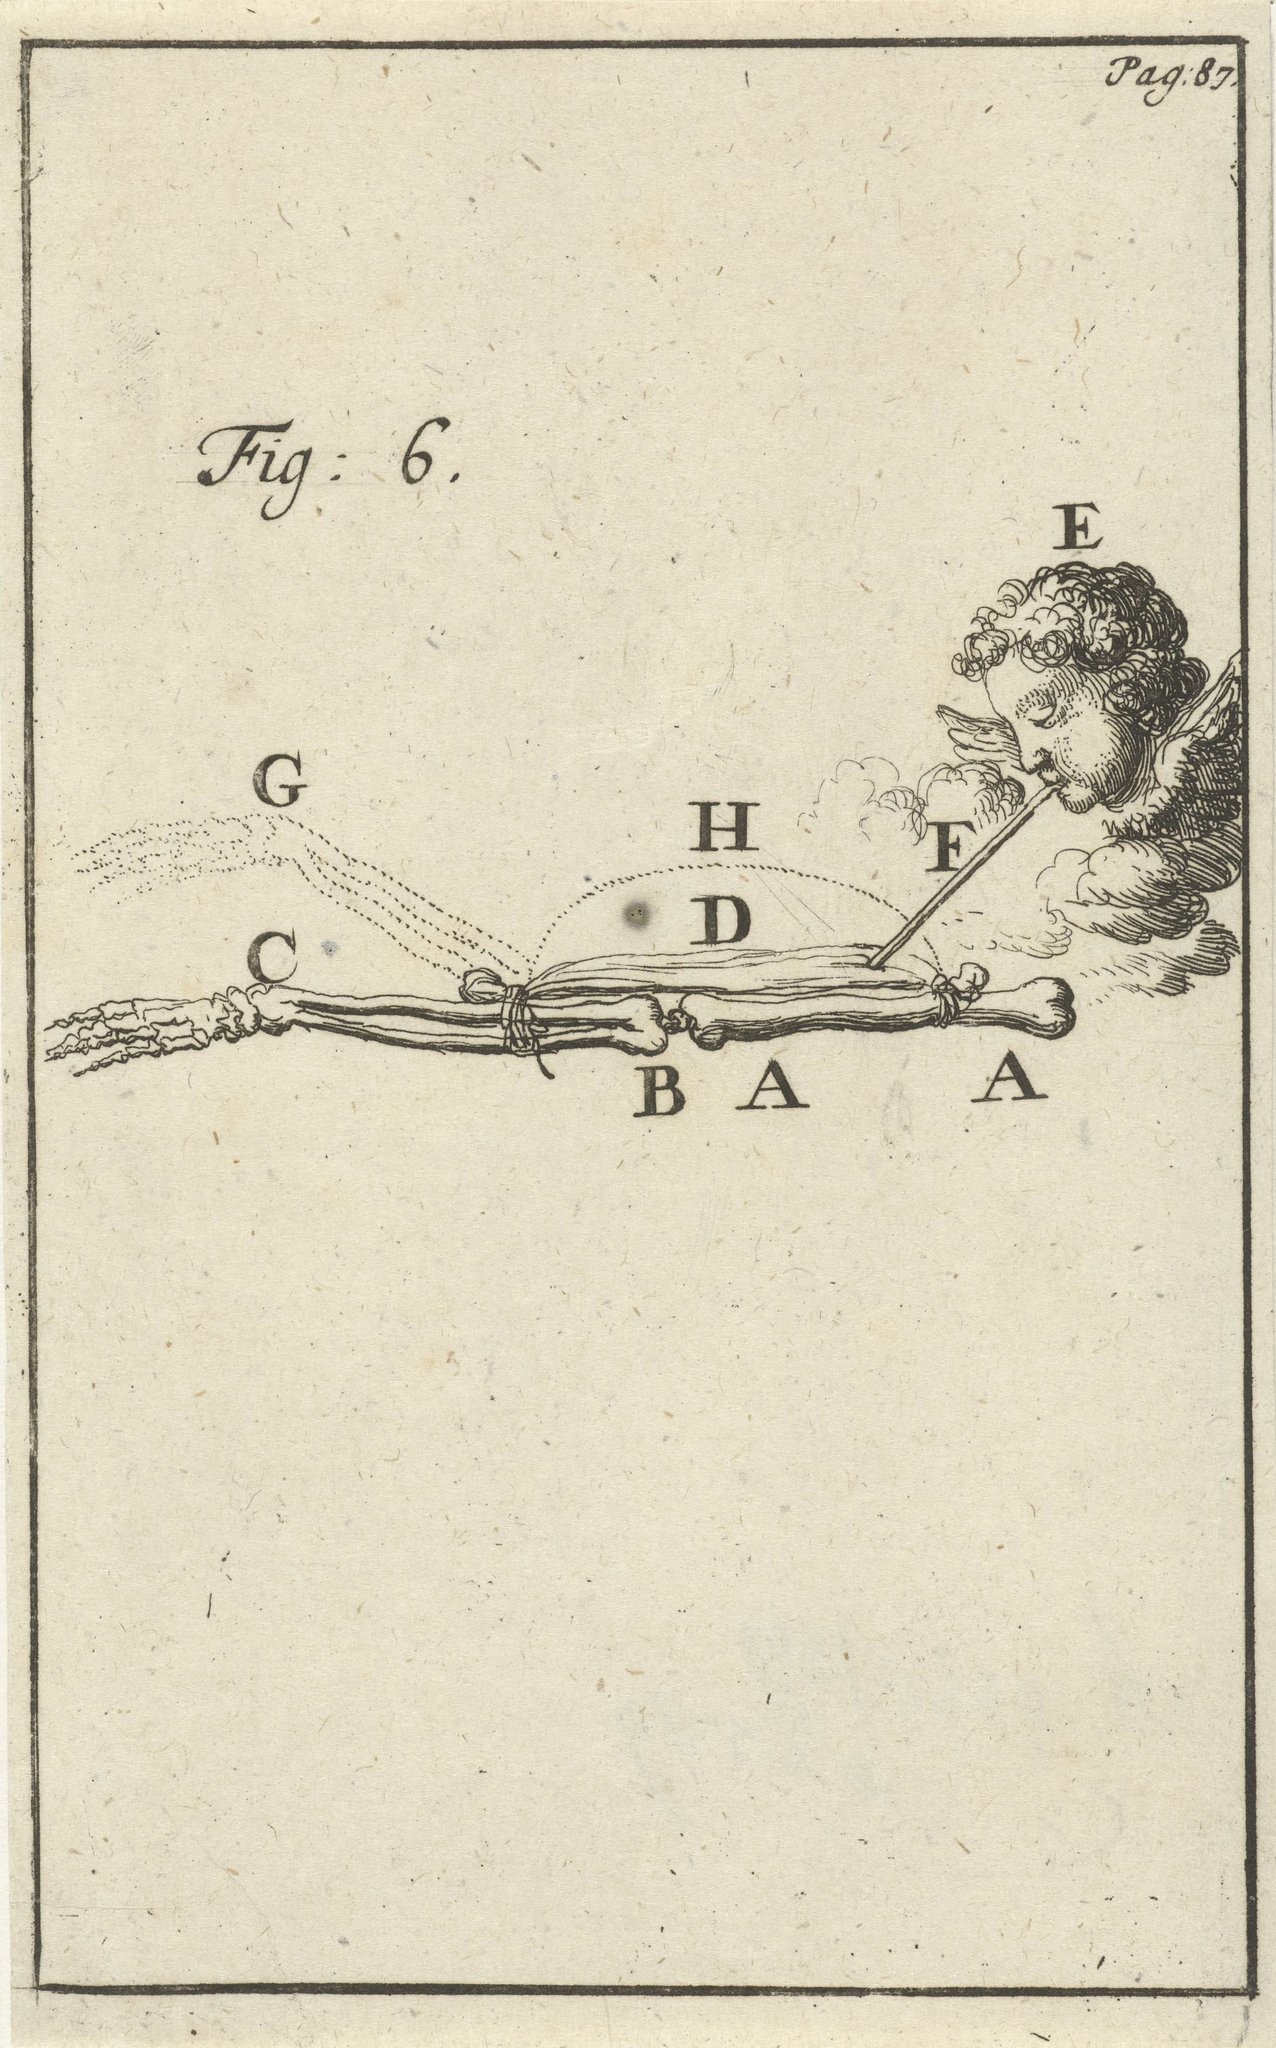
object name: print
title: Beweging van de arm, fig. 6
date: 1683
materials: paper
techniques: etching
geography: amsterdam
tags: physiology and anatomy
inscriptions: collector's mark: Lugt 2228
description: Illustratie opgenomen in: Blankaart, Stephanus. De Kartesiaanse academie ofte Institutie der medicyne. Amsterdam: Jan Claesz ten Hoorn, 1683, p. 87.